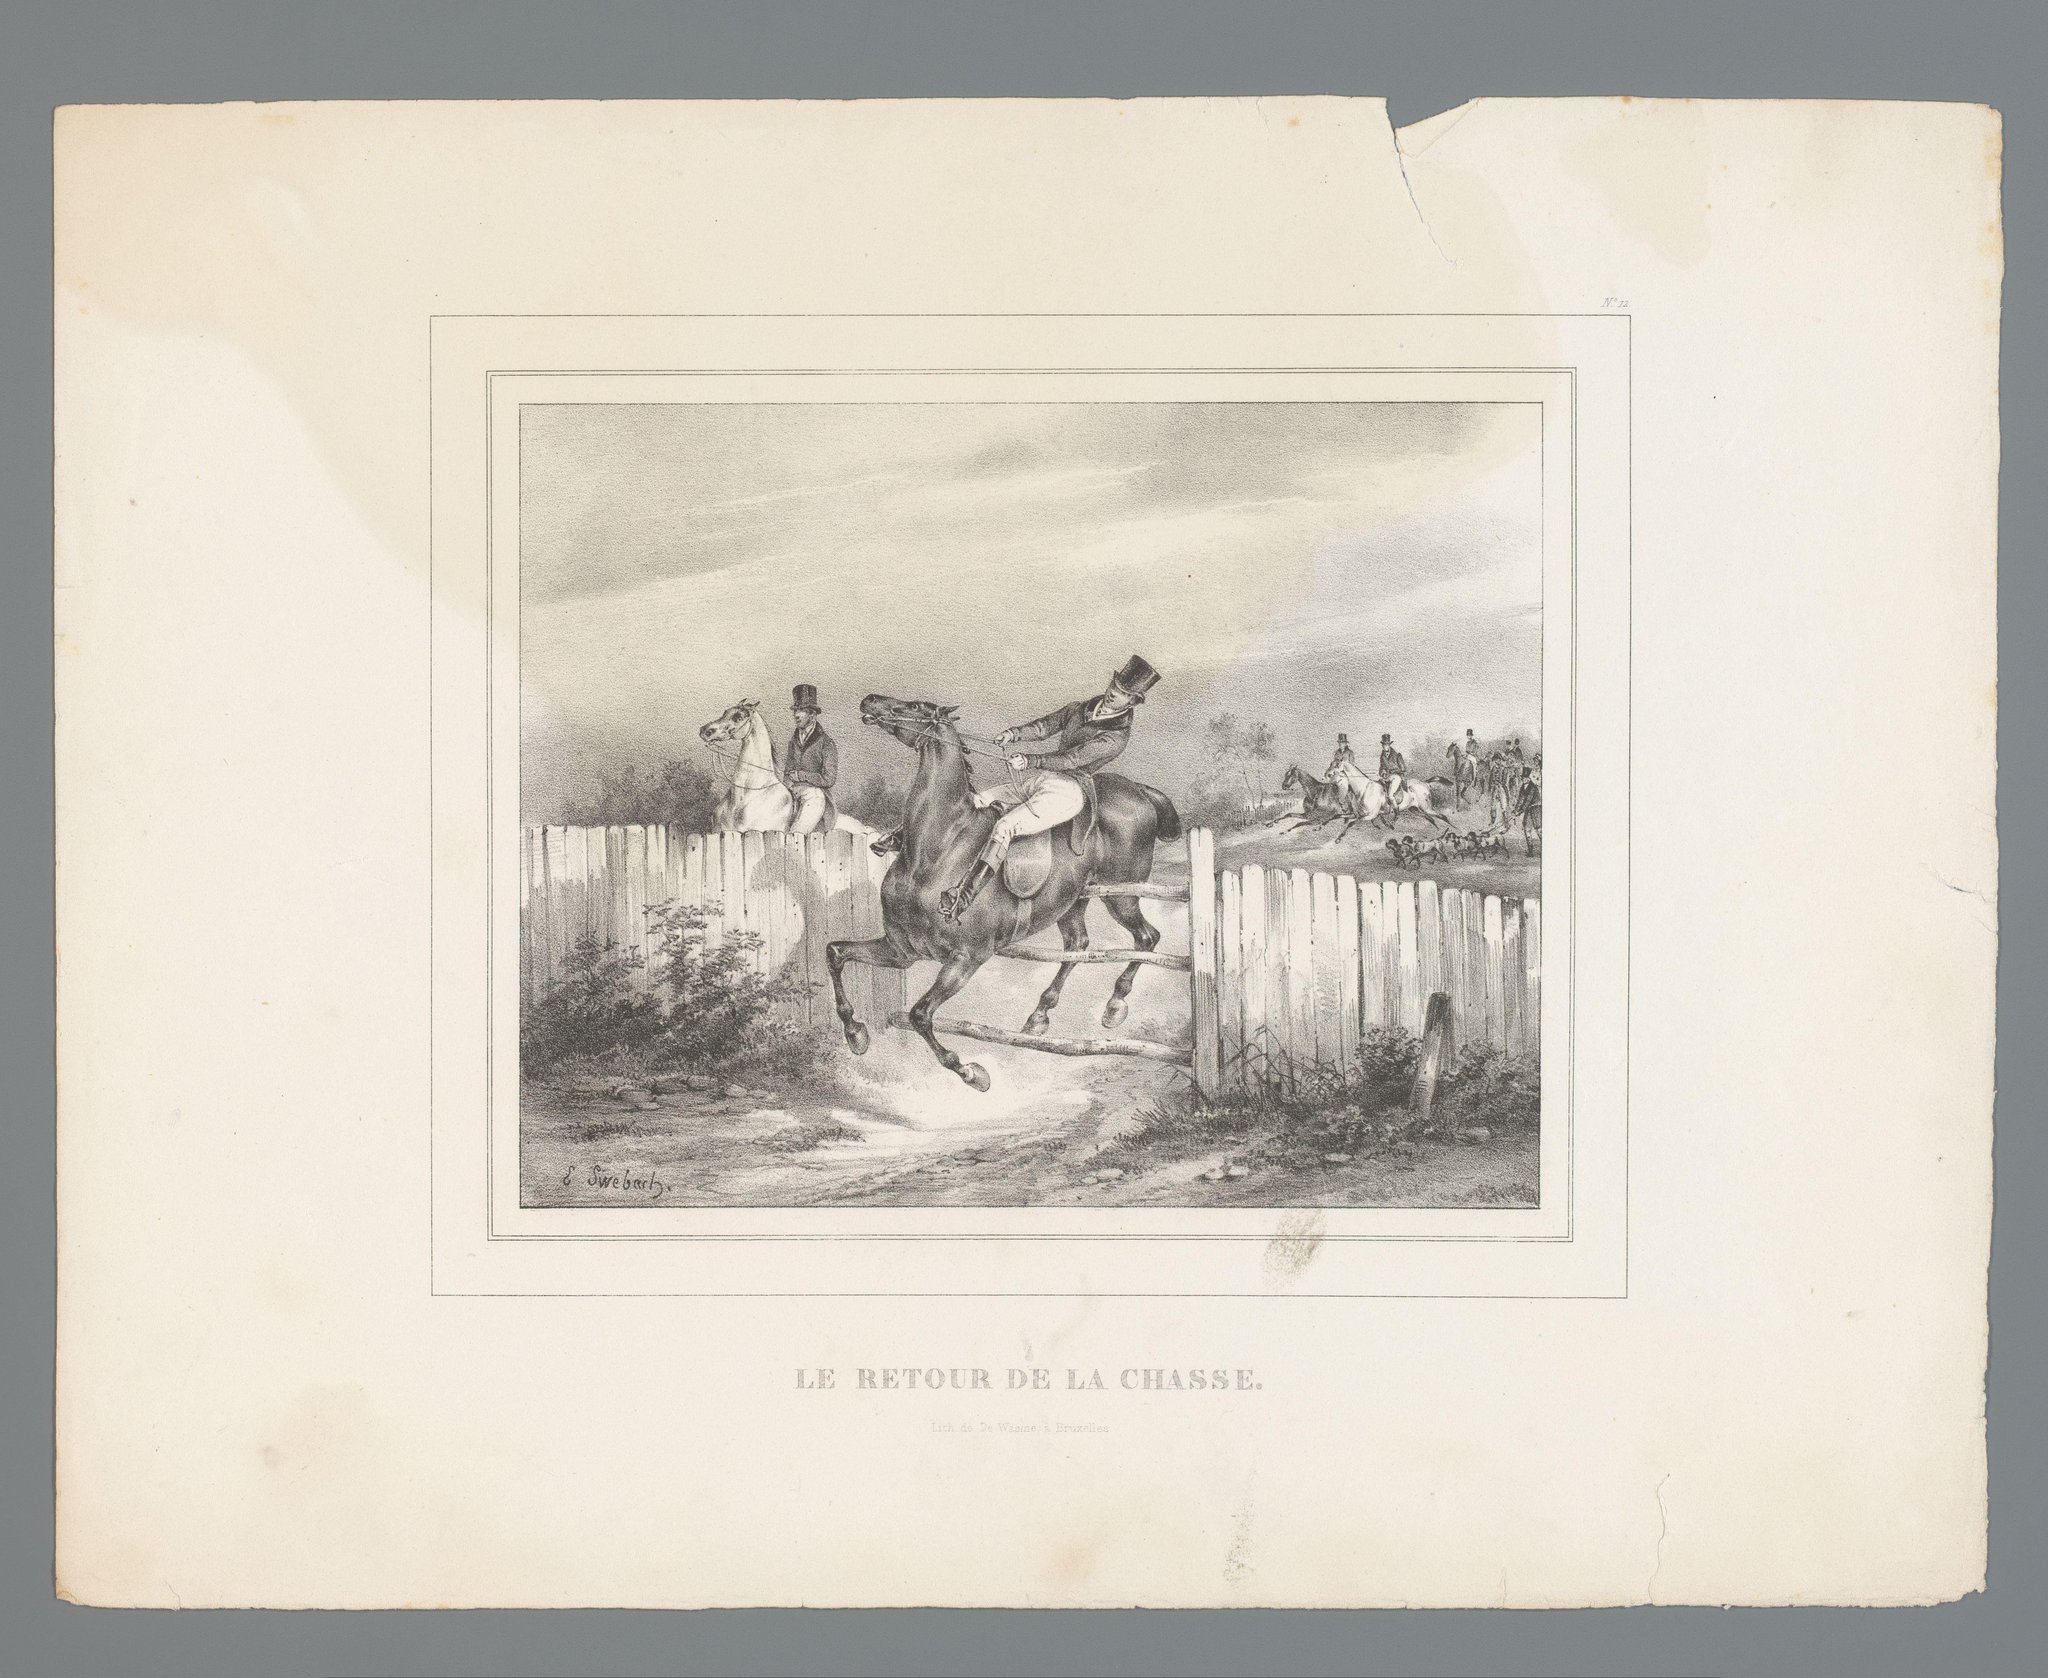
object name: cartoon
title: Ongemakken van de drijfjacht met paarden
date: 1825-1827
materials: paper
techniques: lithograph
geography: brussels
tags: hunting, chase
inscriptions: collector's mark: Lugt 2228